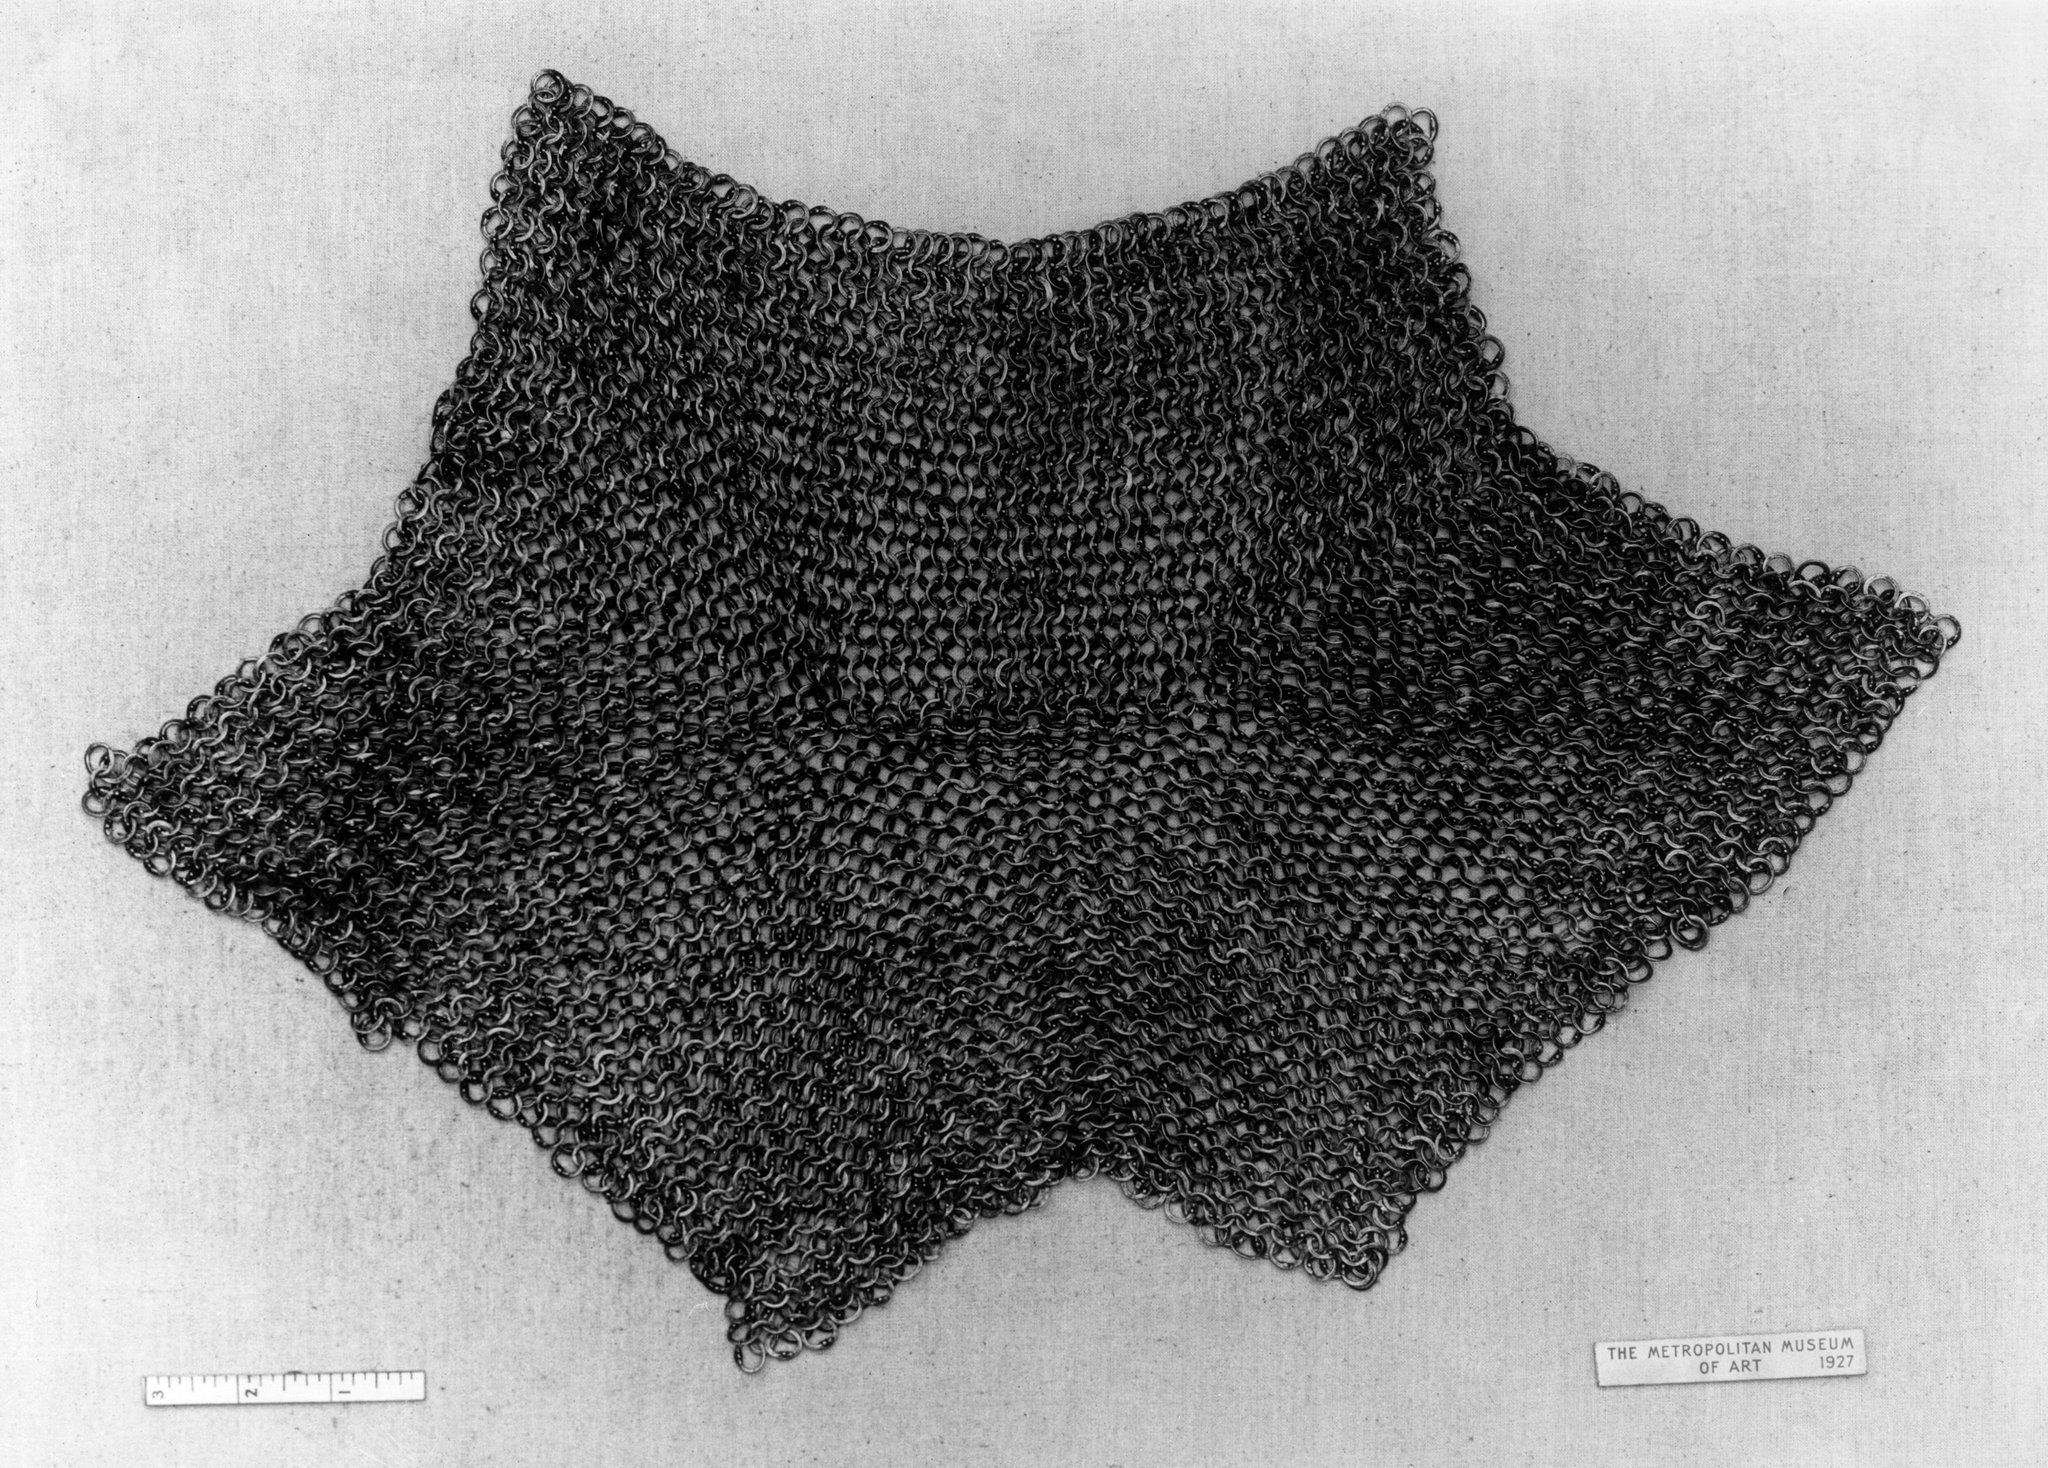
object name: armpit defense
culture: german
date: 1501-1600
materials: steel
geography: germany